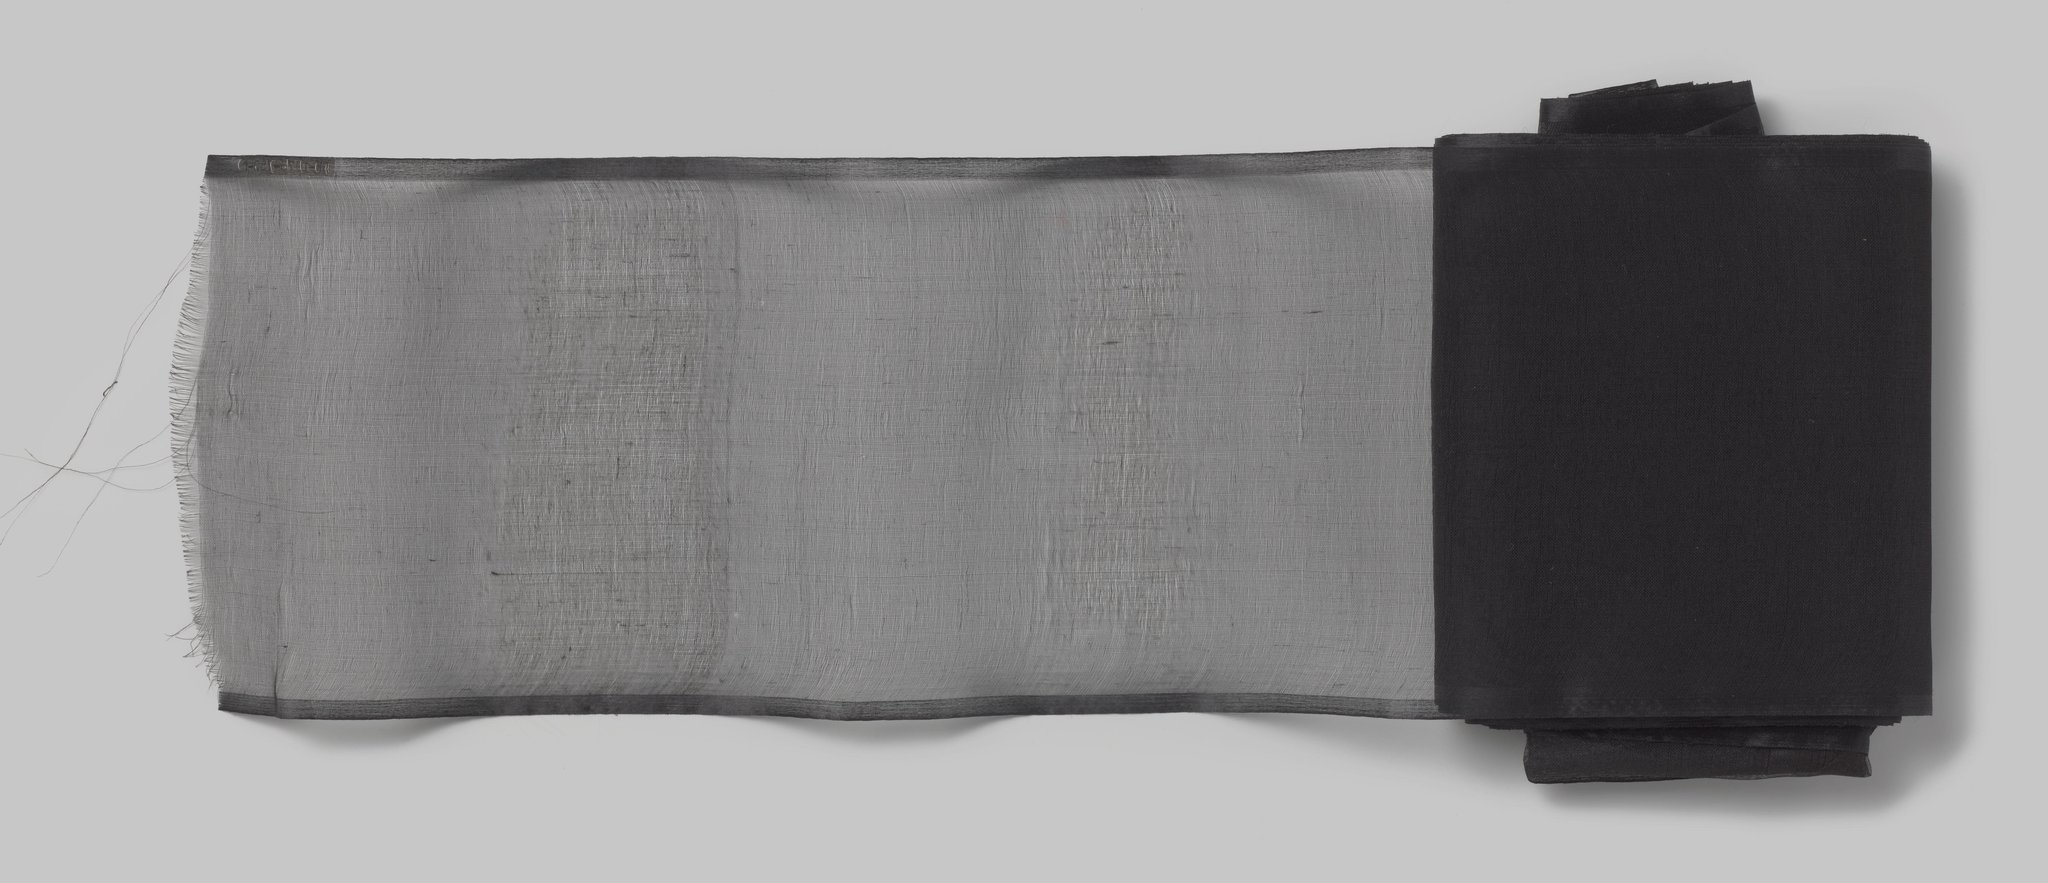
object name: braid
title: Metrage lint van effen zwart zijden gaas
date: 1900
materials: silk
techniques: weave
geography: france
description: Metrage lint van effen zwart zijden gaas.